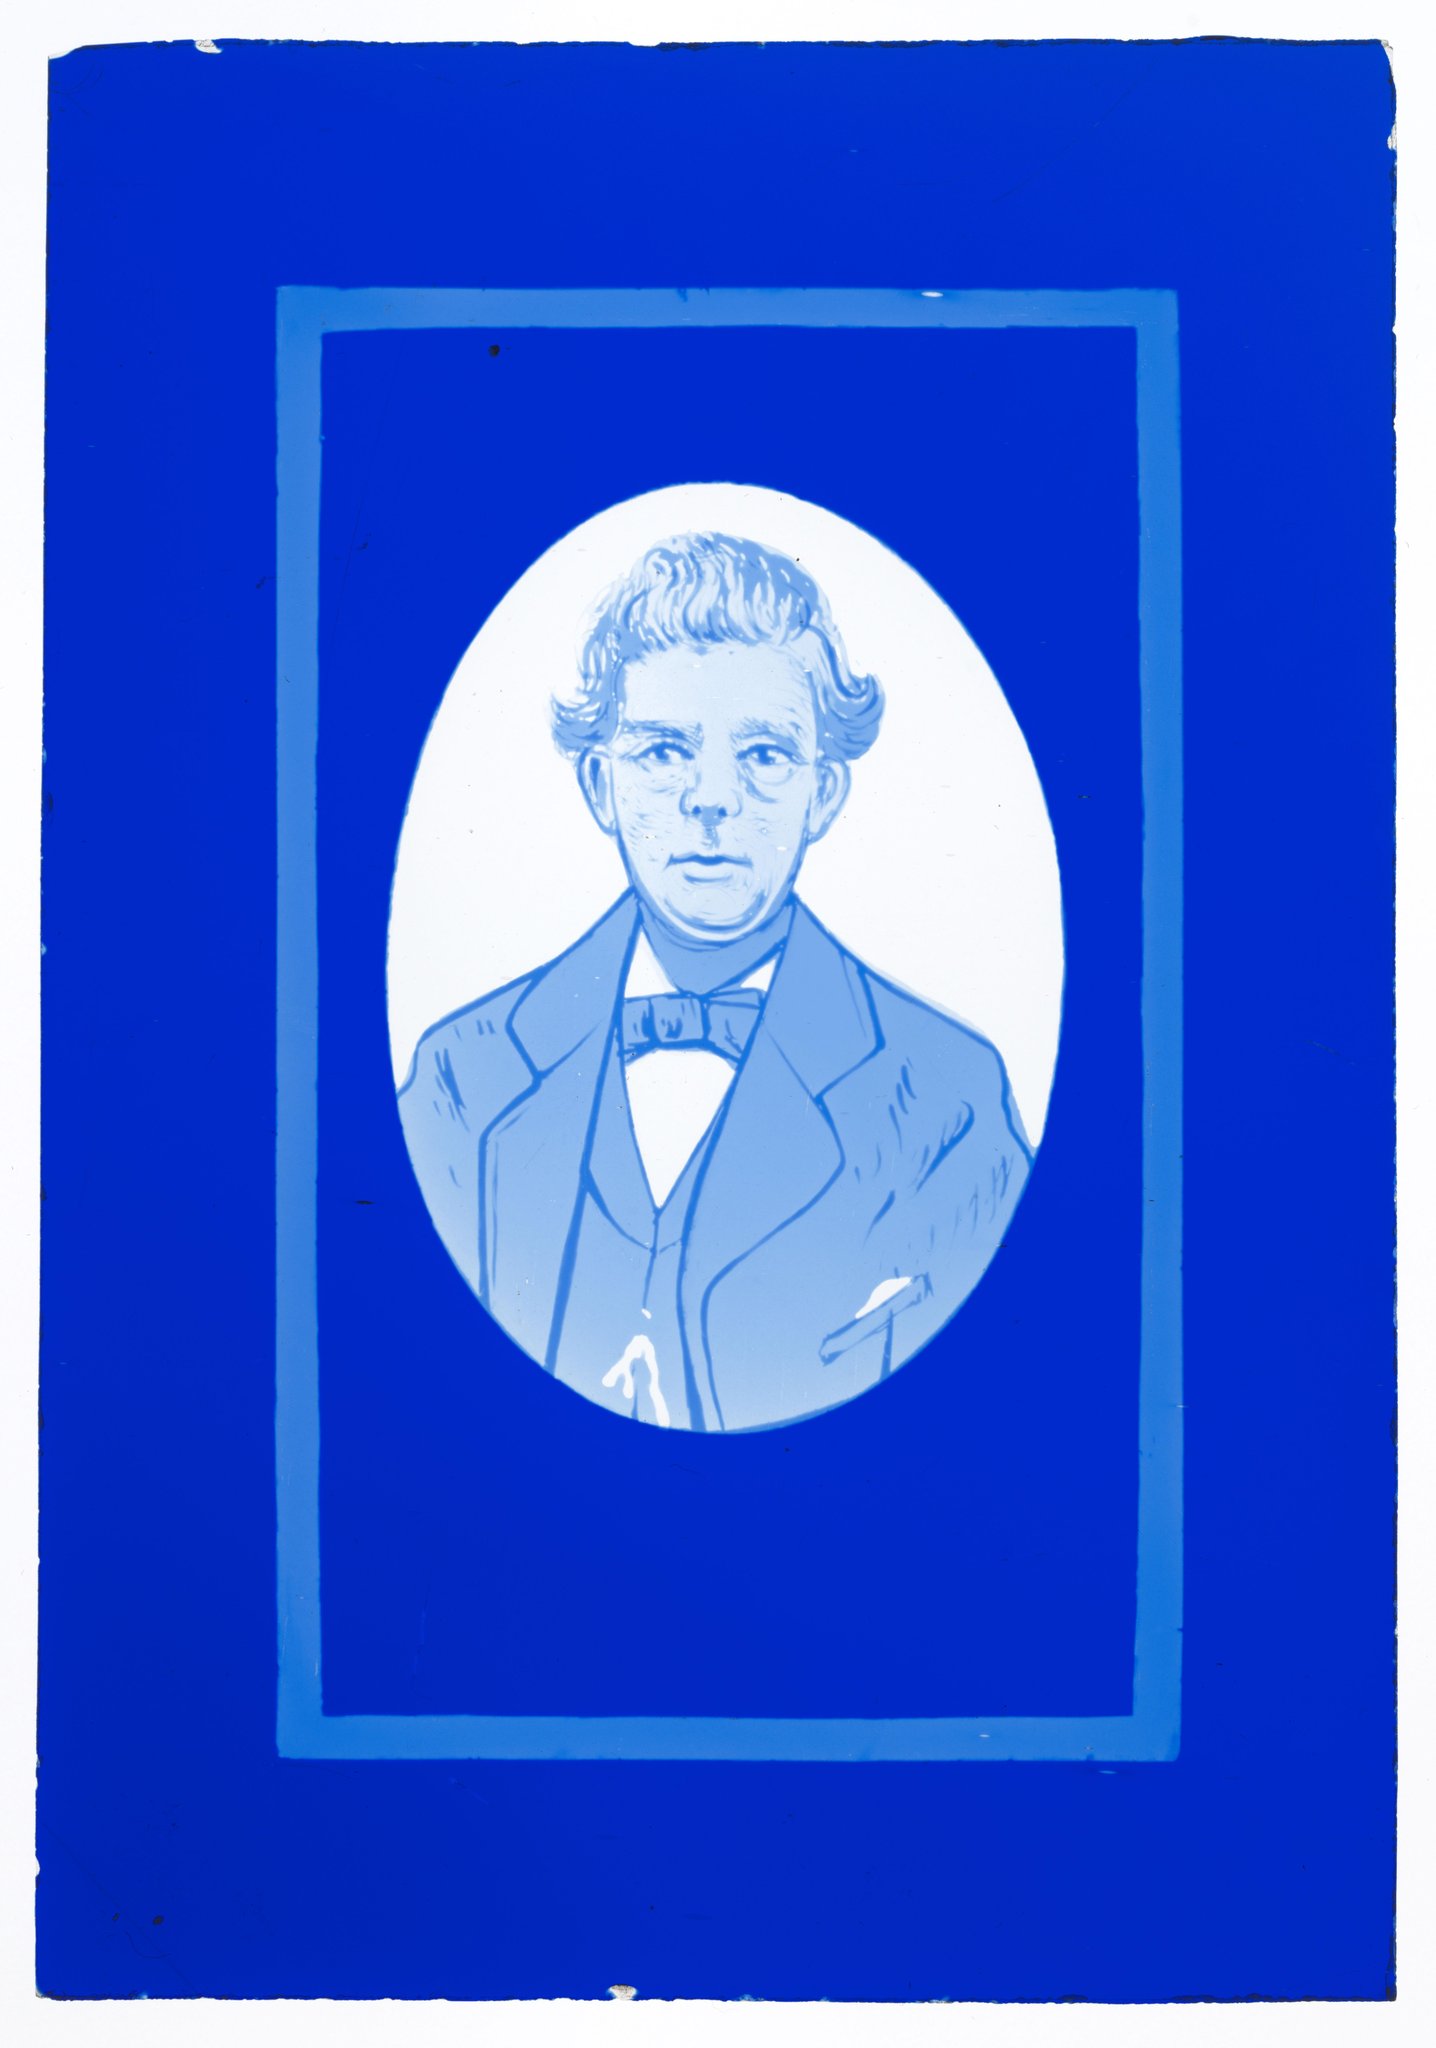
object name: reproduction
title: Reproductie van een fotoportret van een onbekende man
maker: Anonymous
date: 1875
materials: glass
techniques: etching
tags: anonymous historical person portrayed